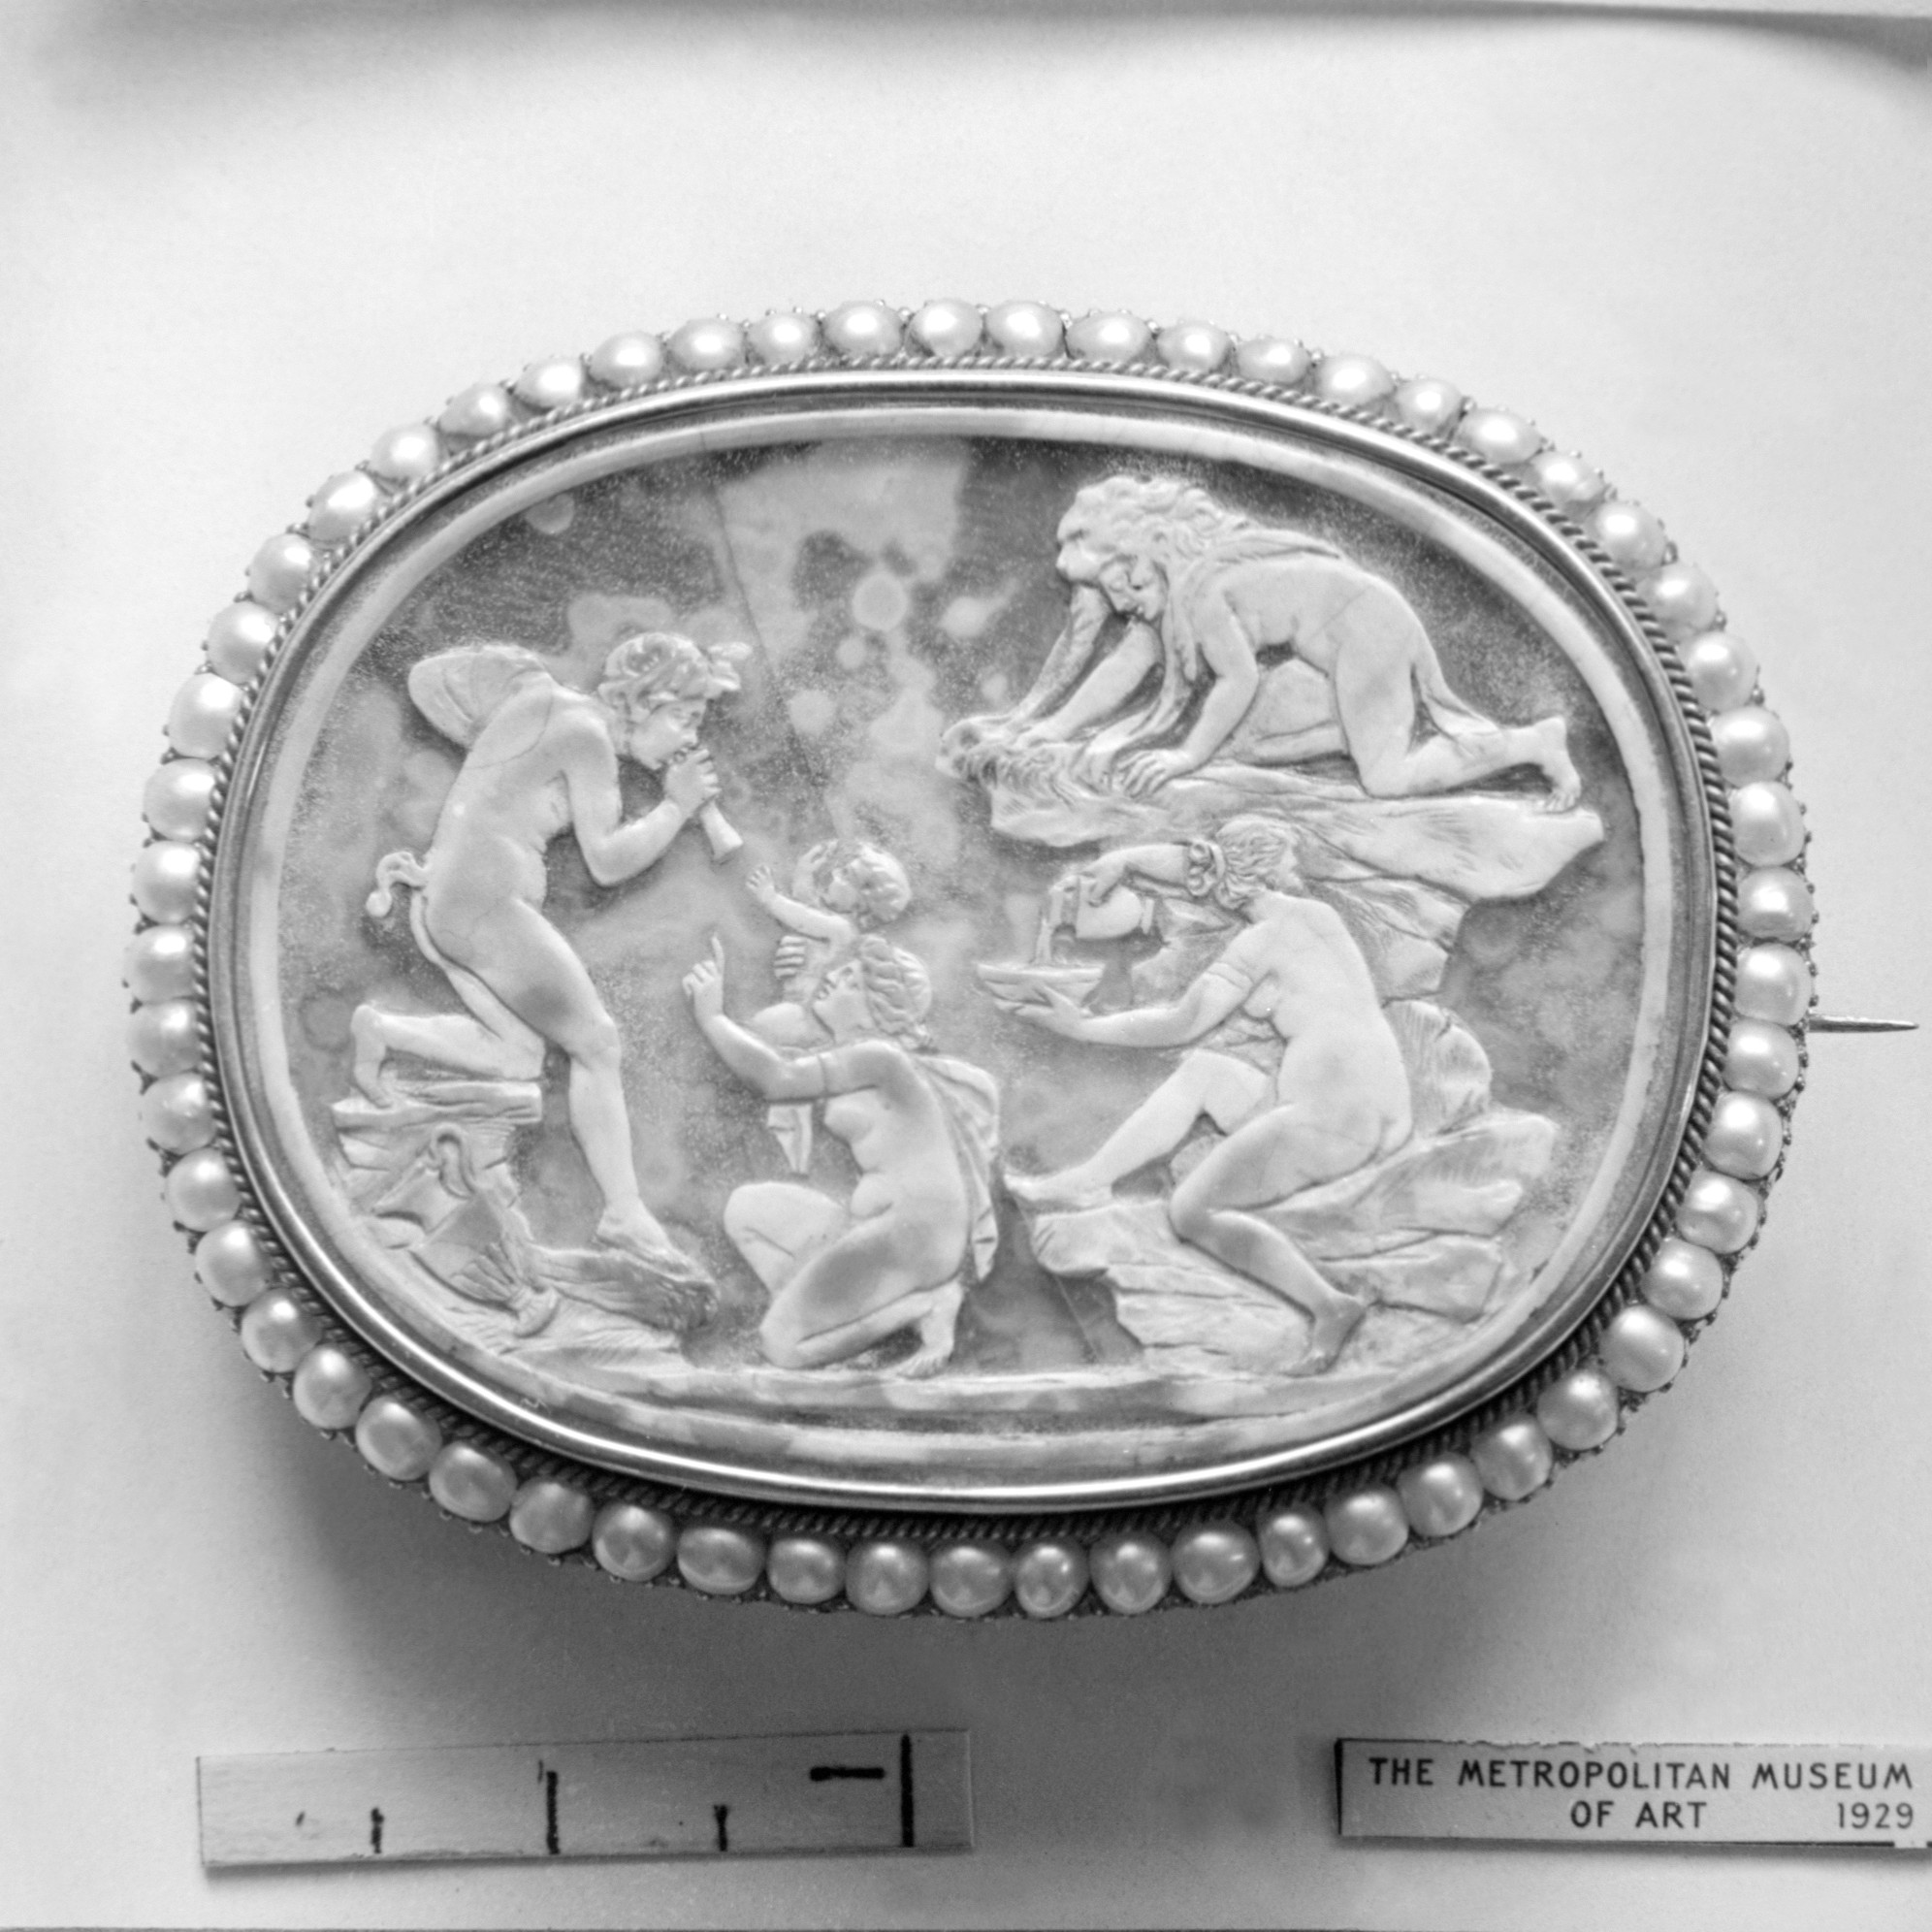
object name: cameo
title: Bacchic episode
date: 1801-1900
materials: gold, pearl, gemstone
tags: female nudes